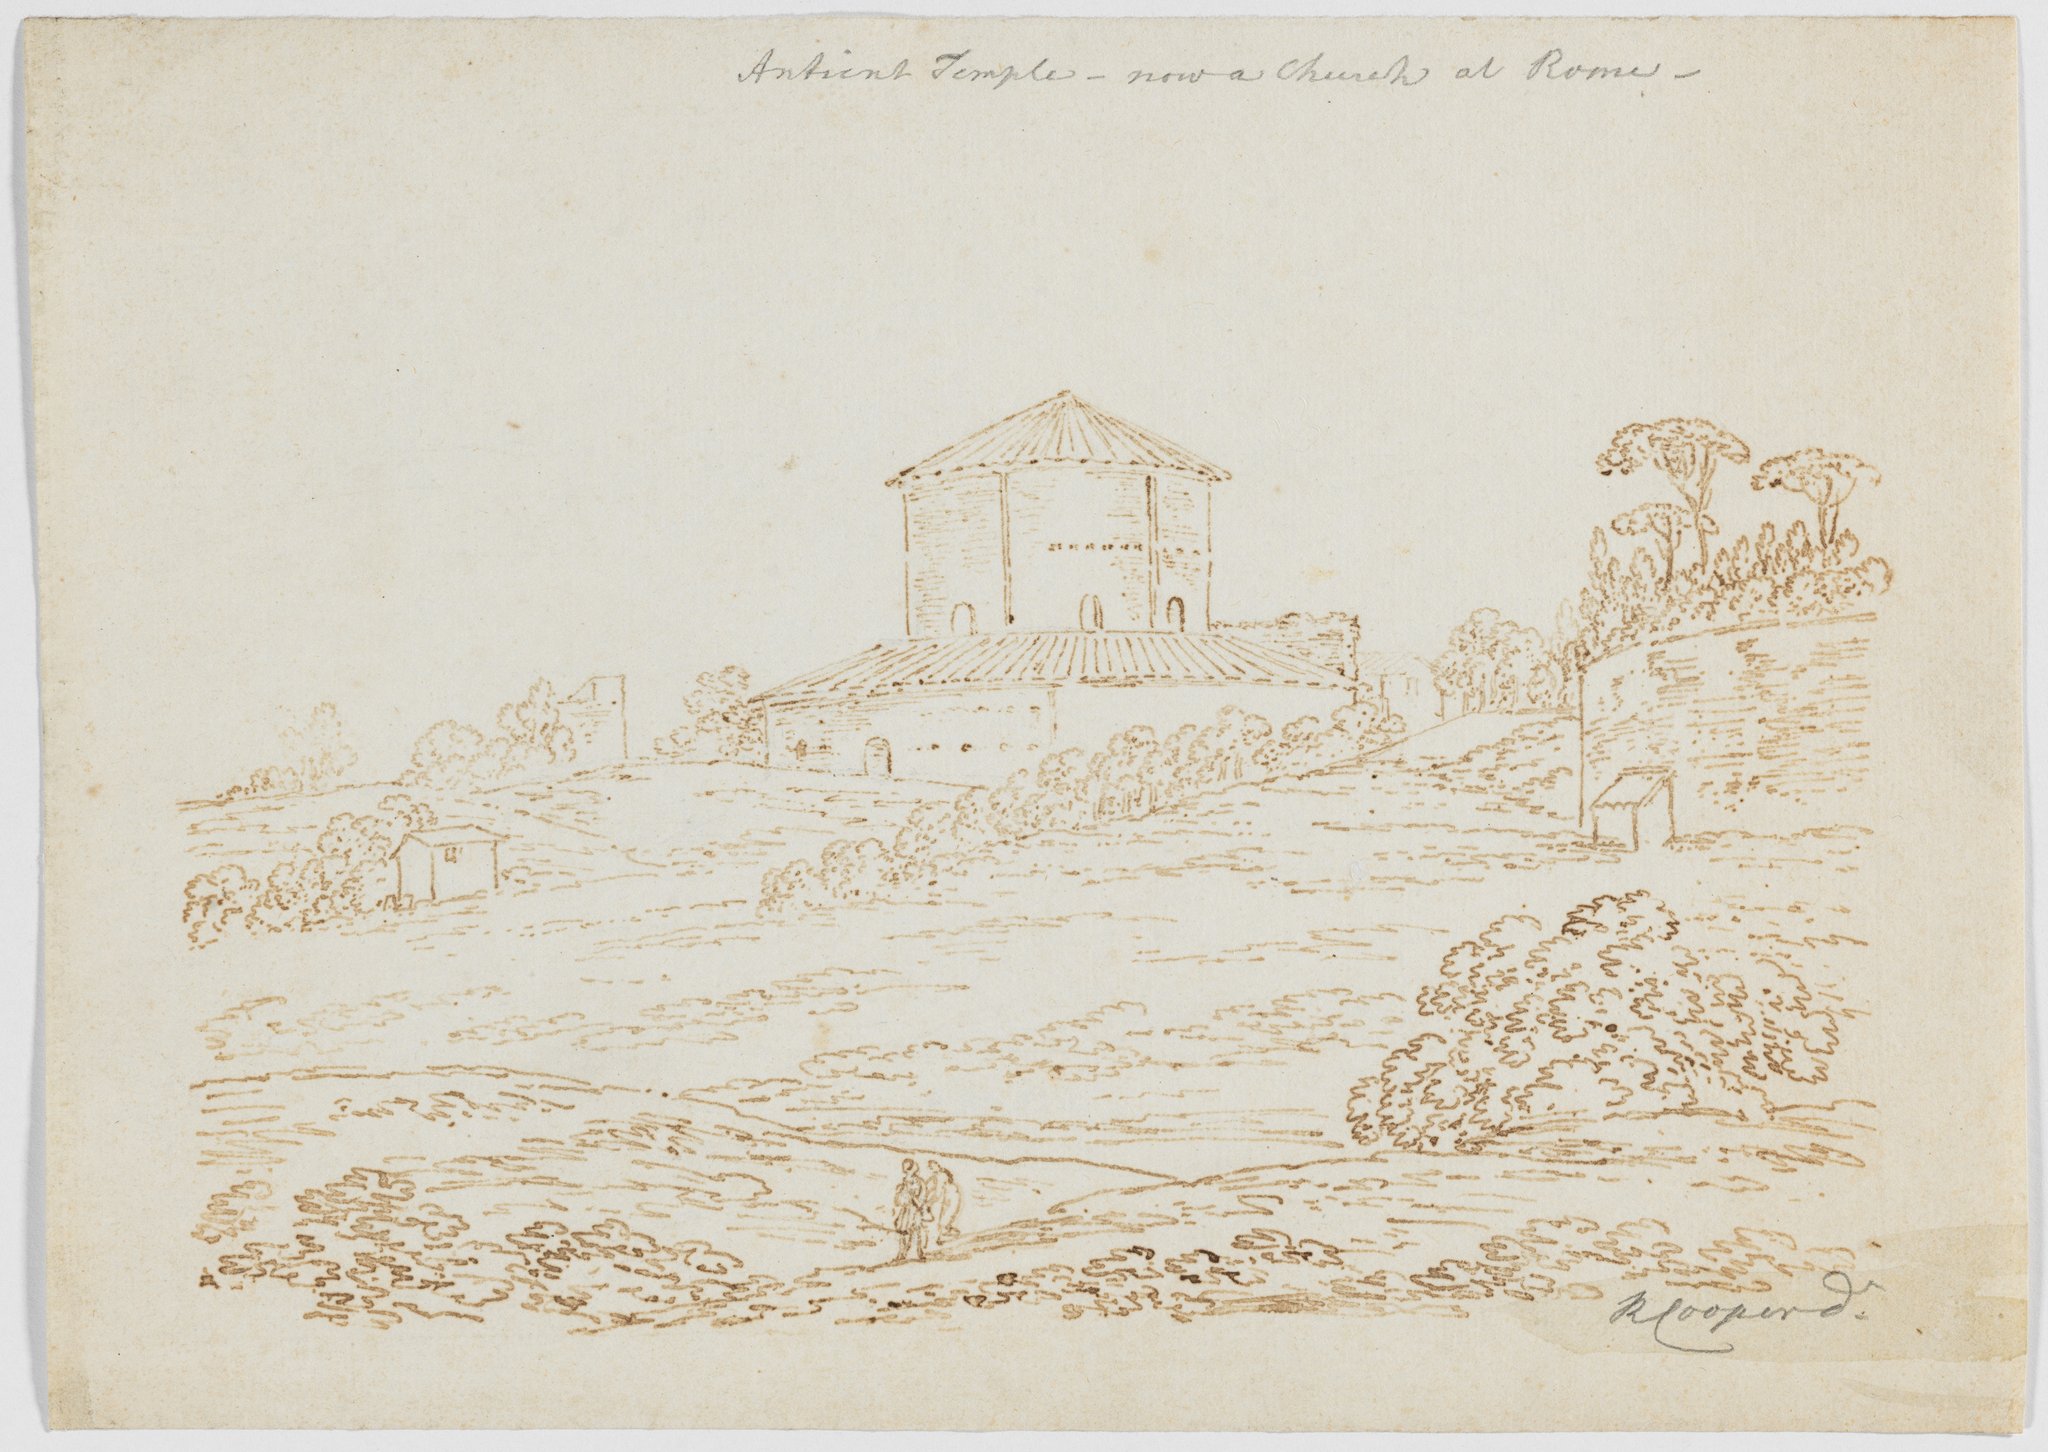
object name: drawing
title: Ancient Temple – now a Church, at Rome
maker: richard cooper ii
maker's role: artist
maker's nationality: british, scottish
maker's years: 1740-1822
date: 1774-1775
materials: graphite, ink, iron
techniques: printmaking, drawing